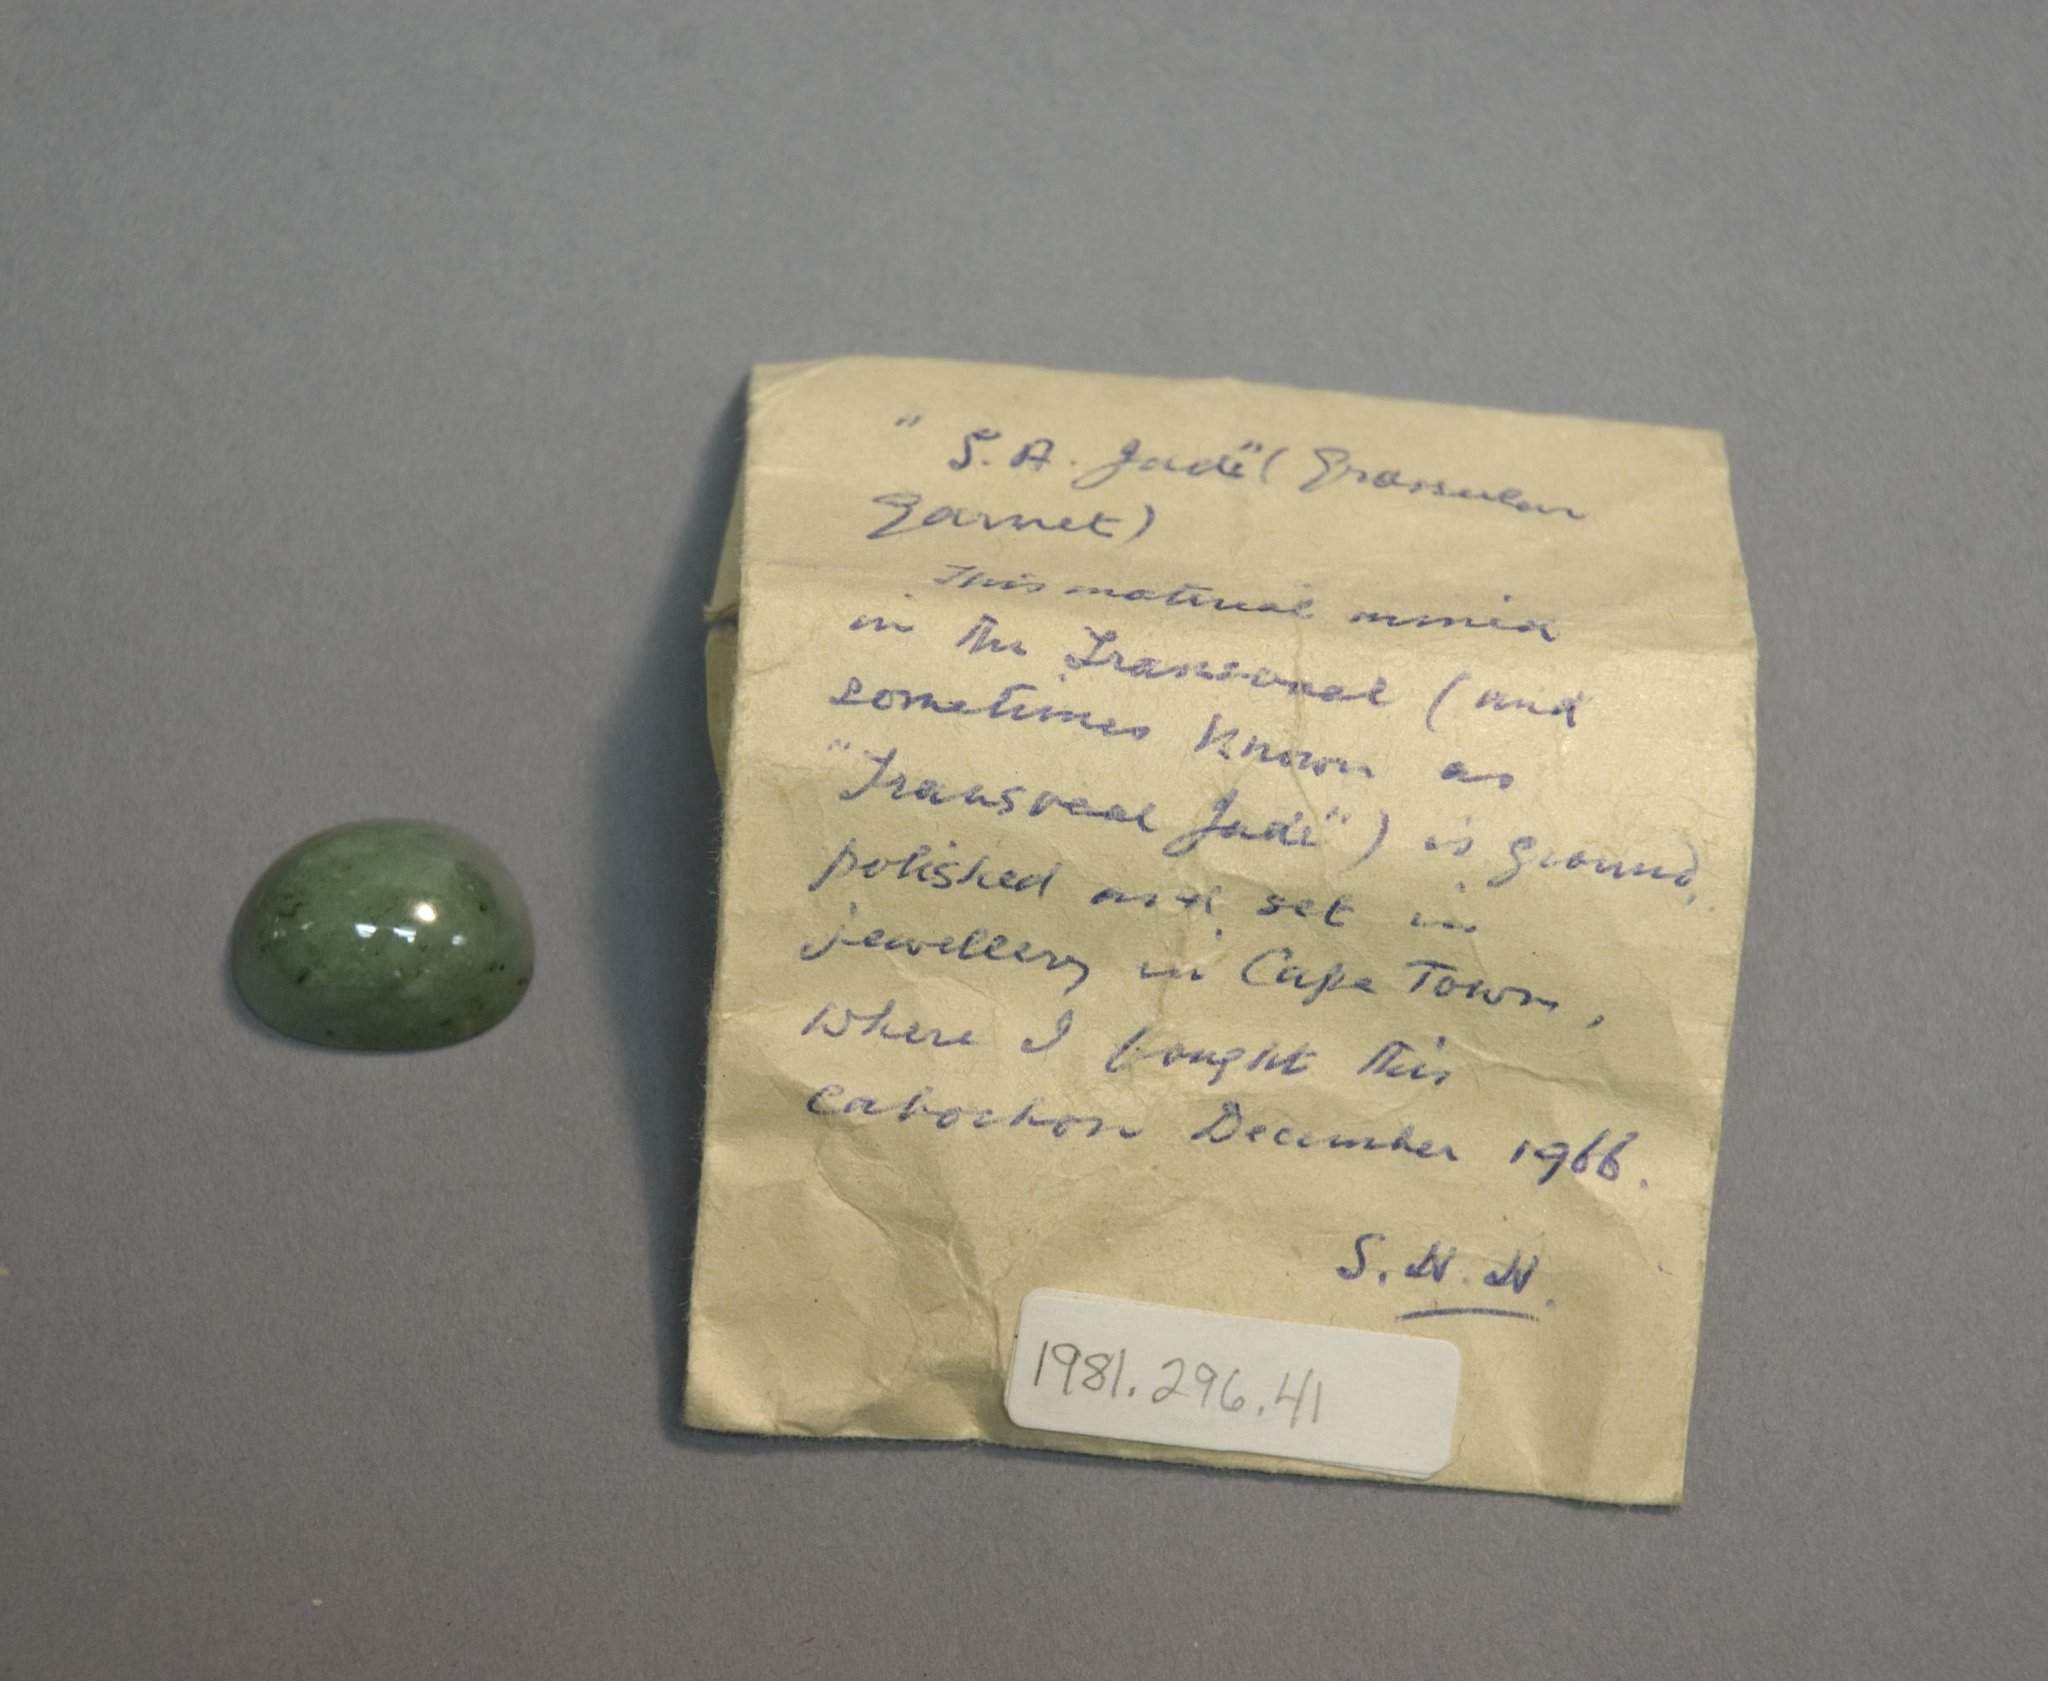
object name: jade carving material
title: Sample of "South African jade" in Paper Bag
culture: chinese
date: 1901-2000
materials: jade